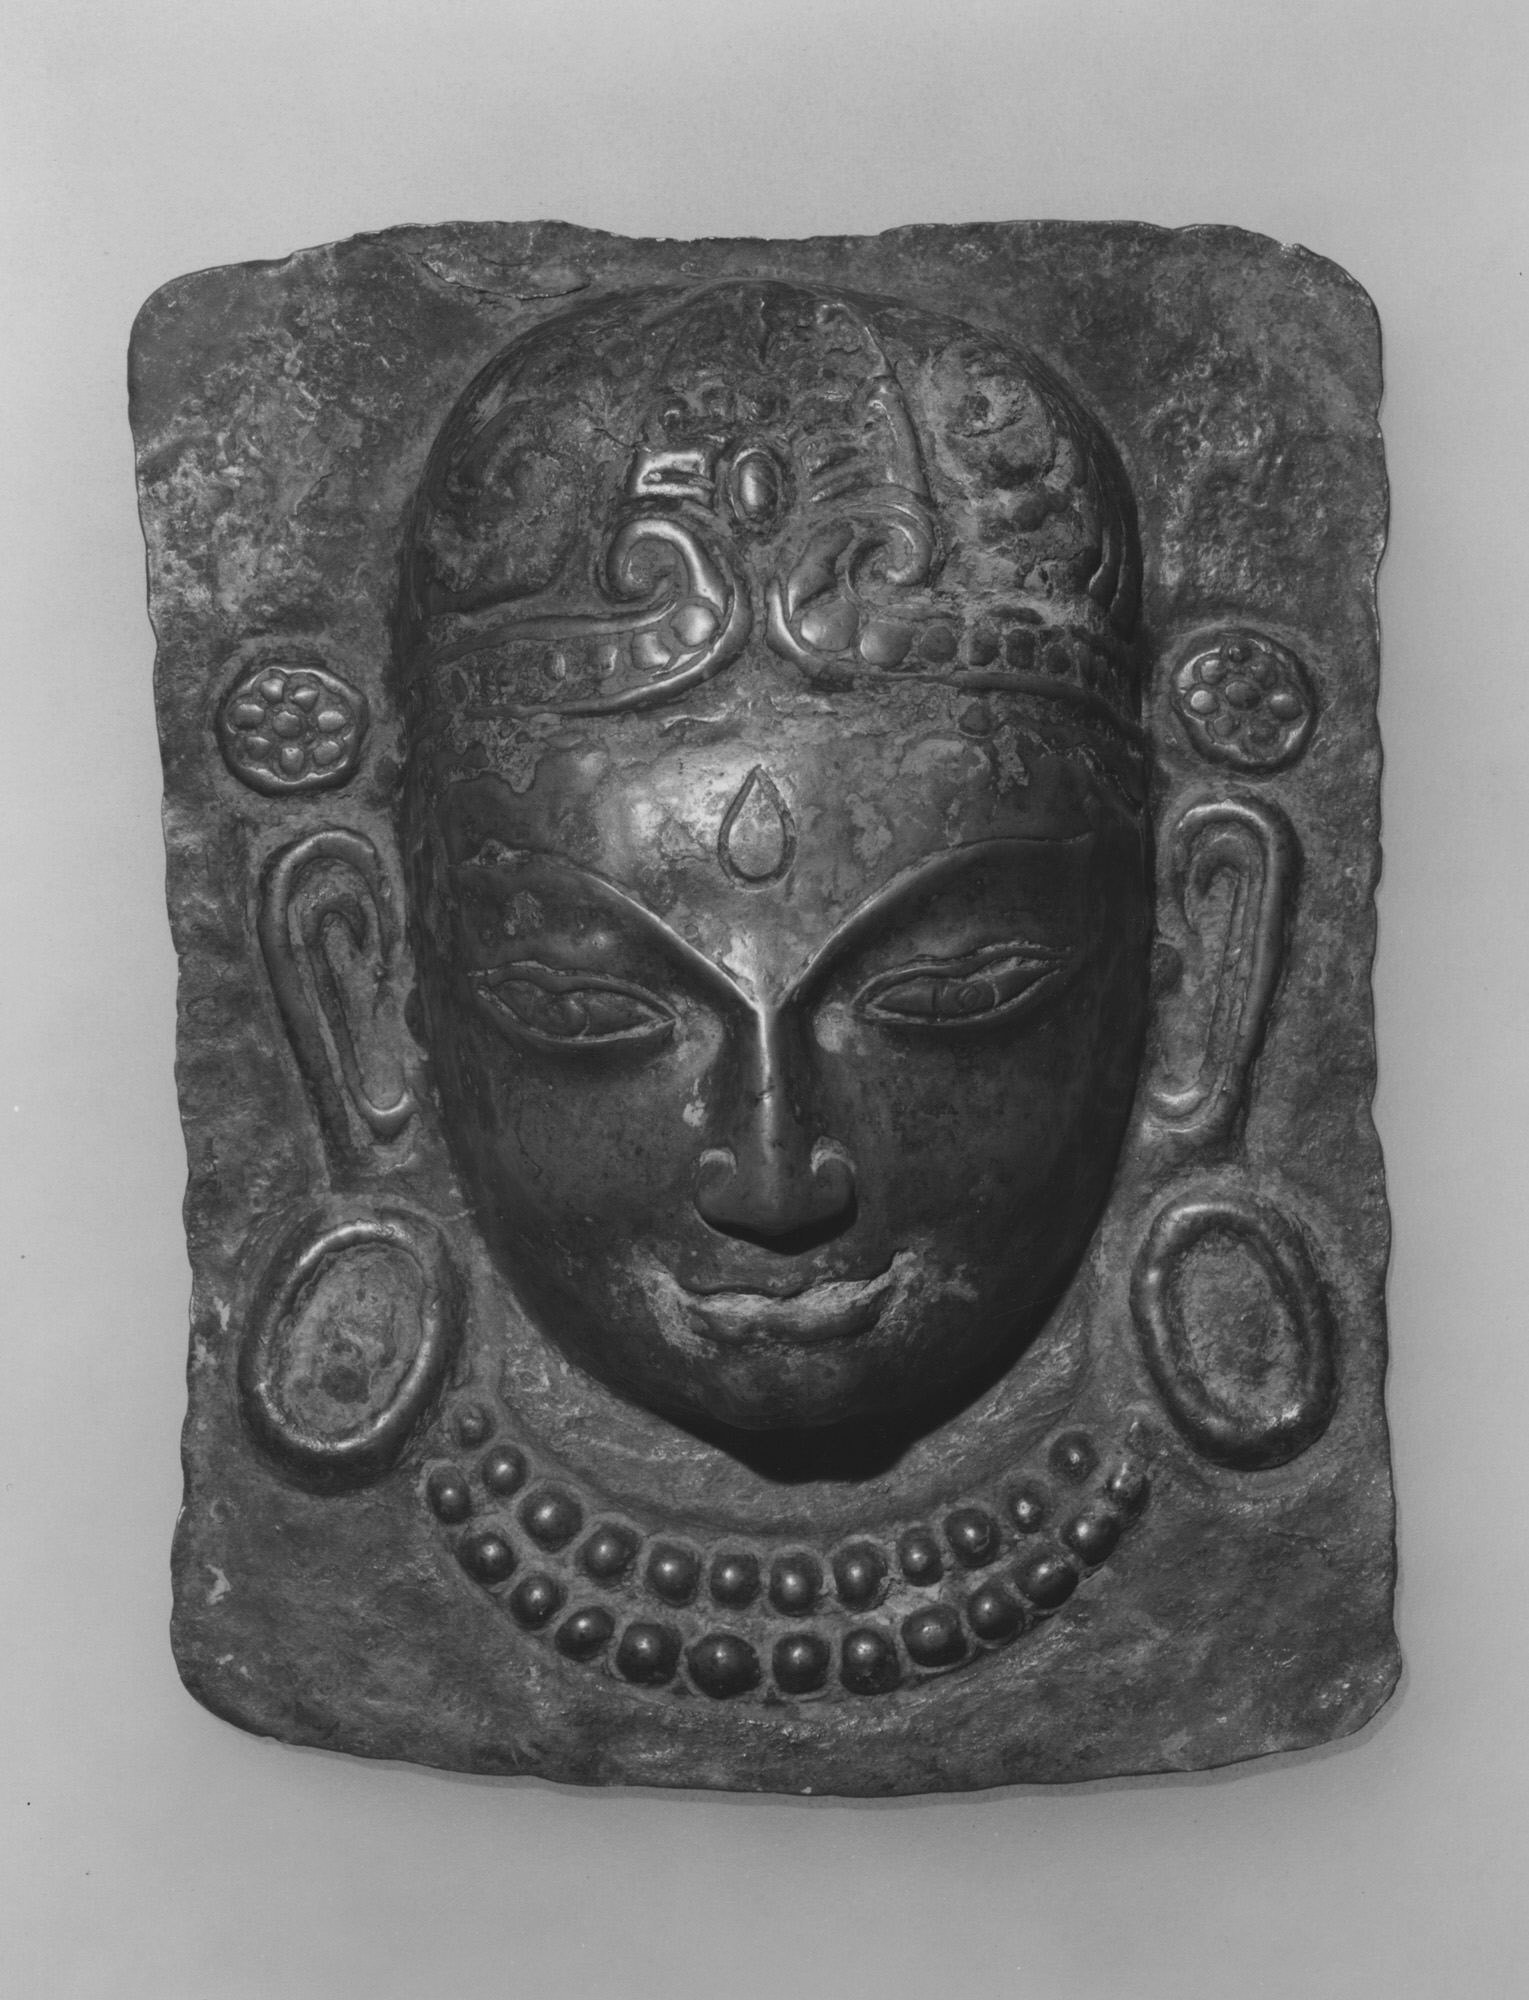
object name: relief plaque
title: Relief Plaque of Hindu Deity, Probably Processional: Face of a Deity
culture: nepali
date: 1301-1600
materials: copper alloy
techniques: repoussé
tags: hinduism